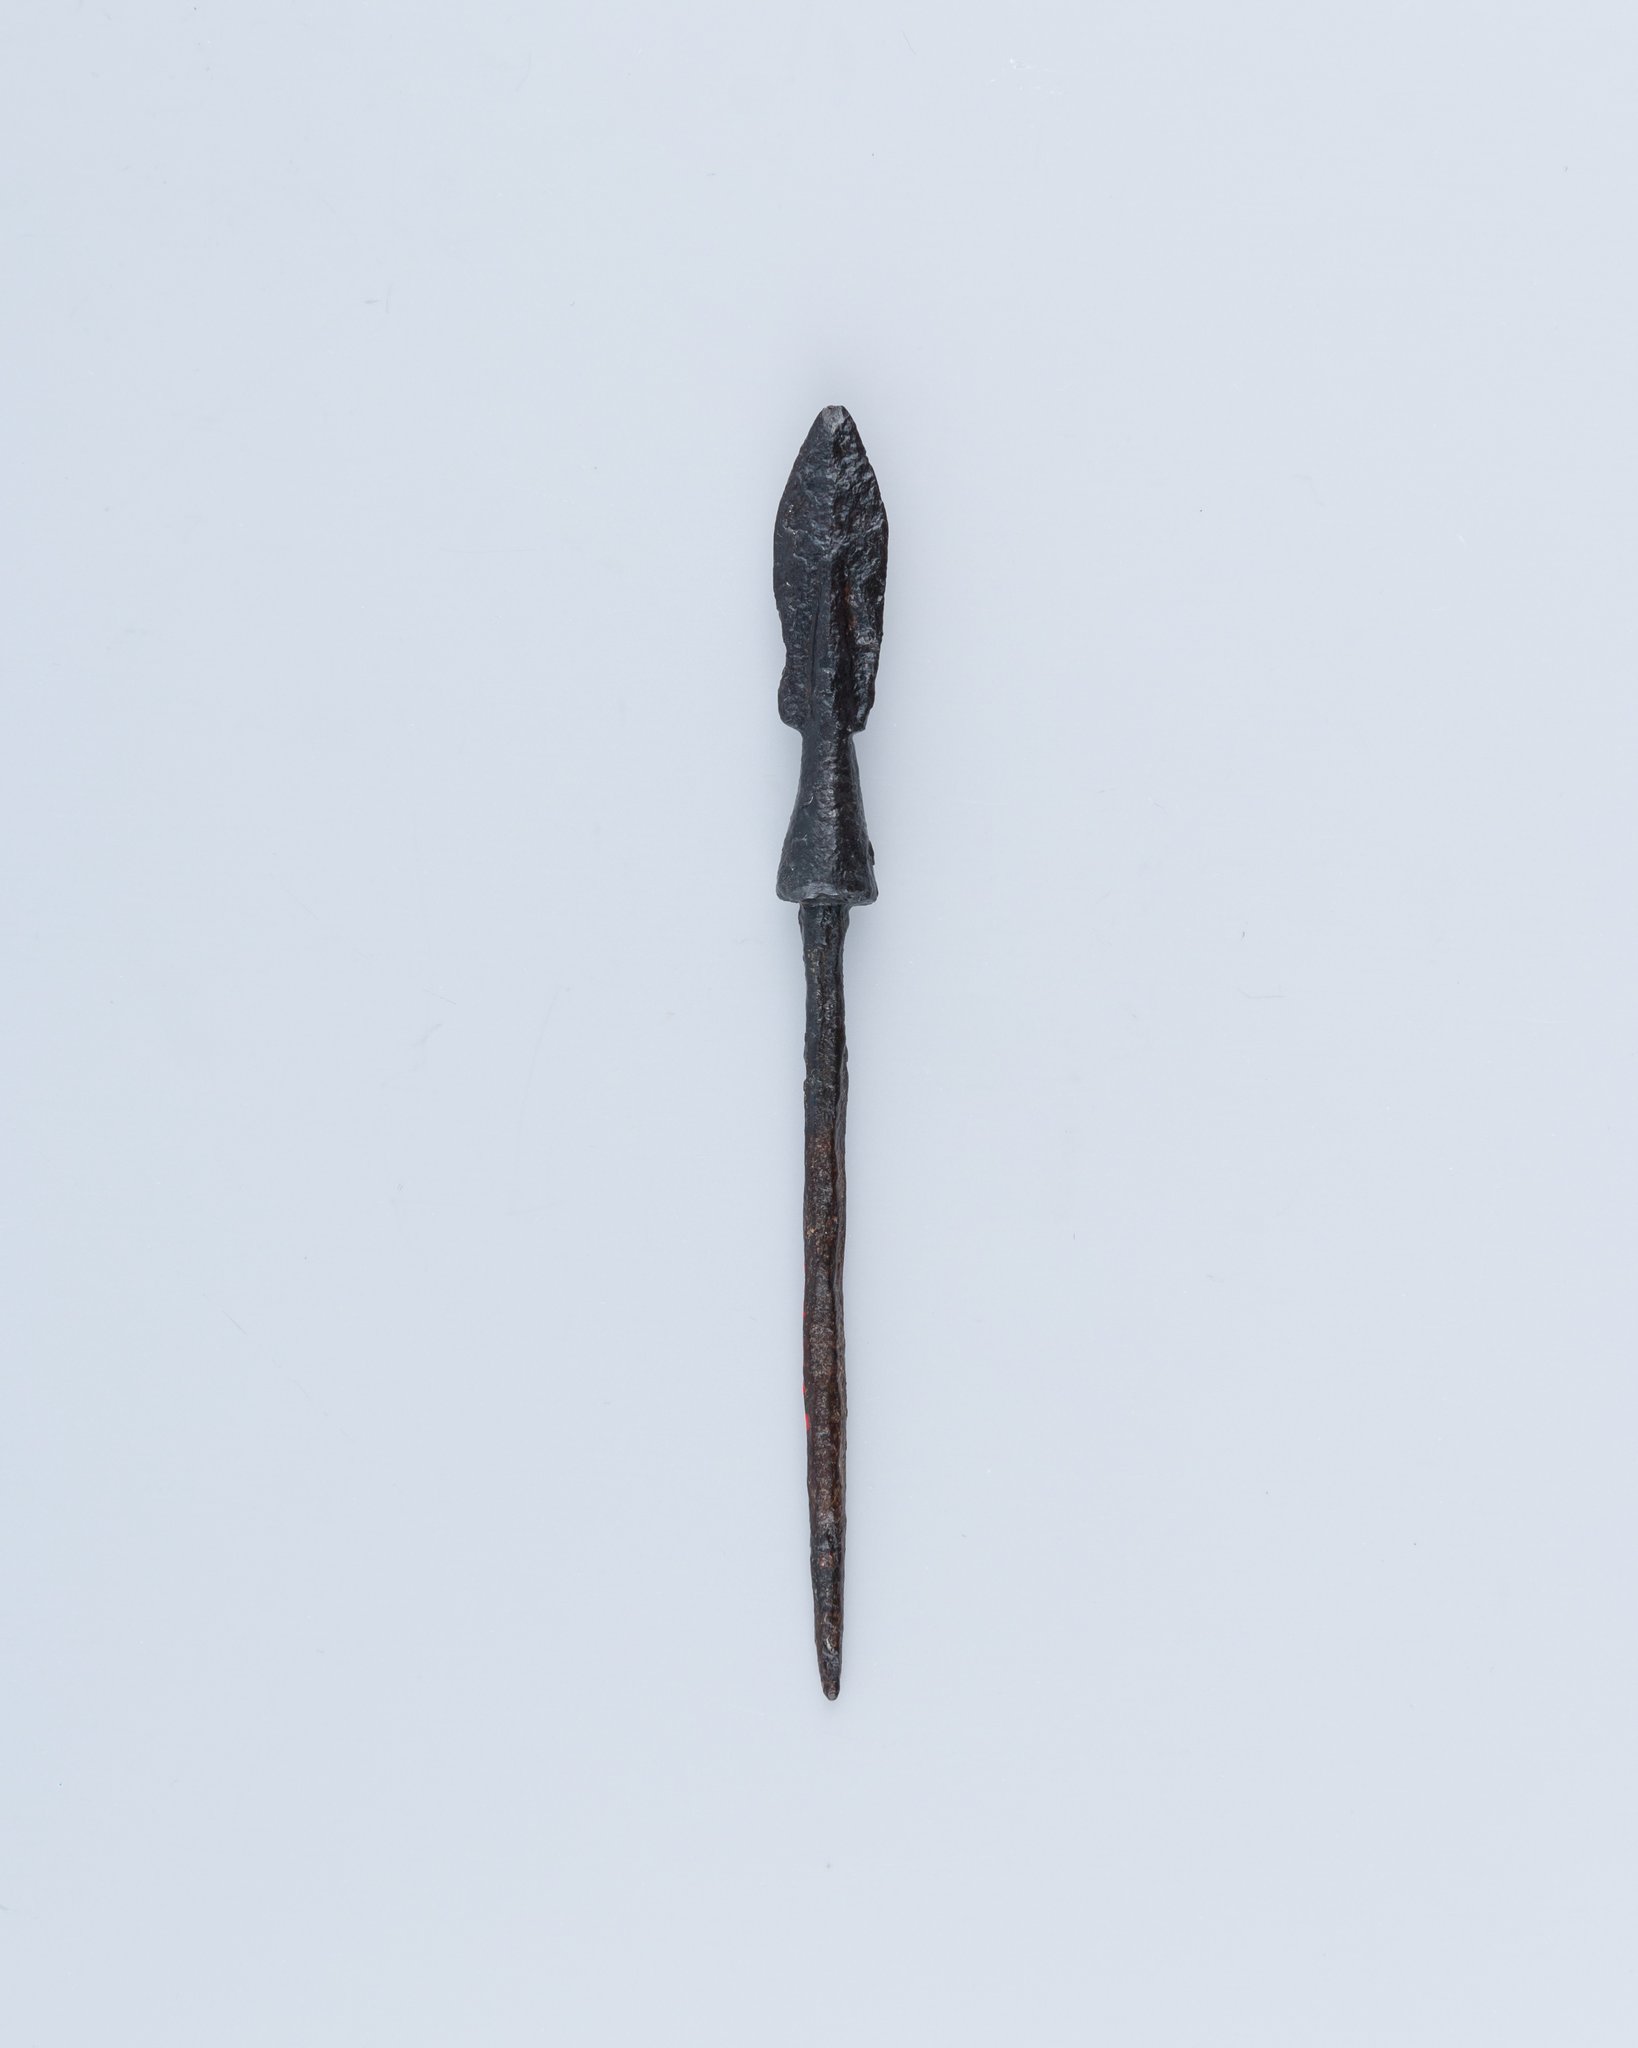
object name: arrowhead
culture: tibetan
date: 1401-1700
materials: iron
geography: tibet